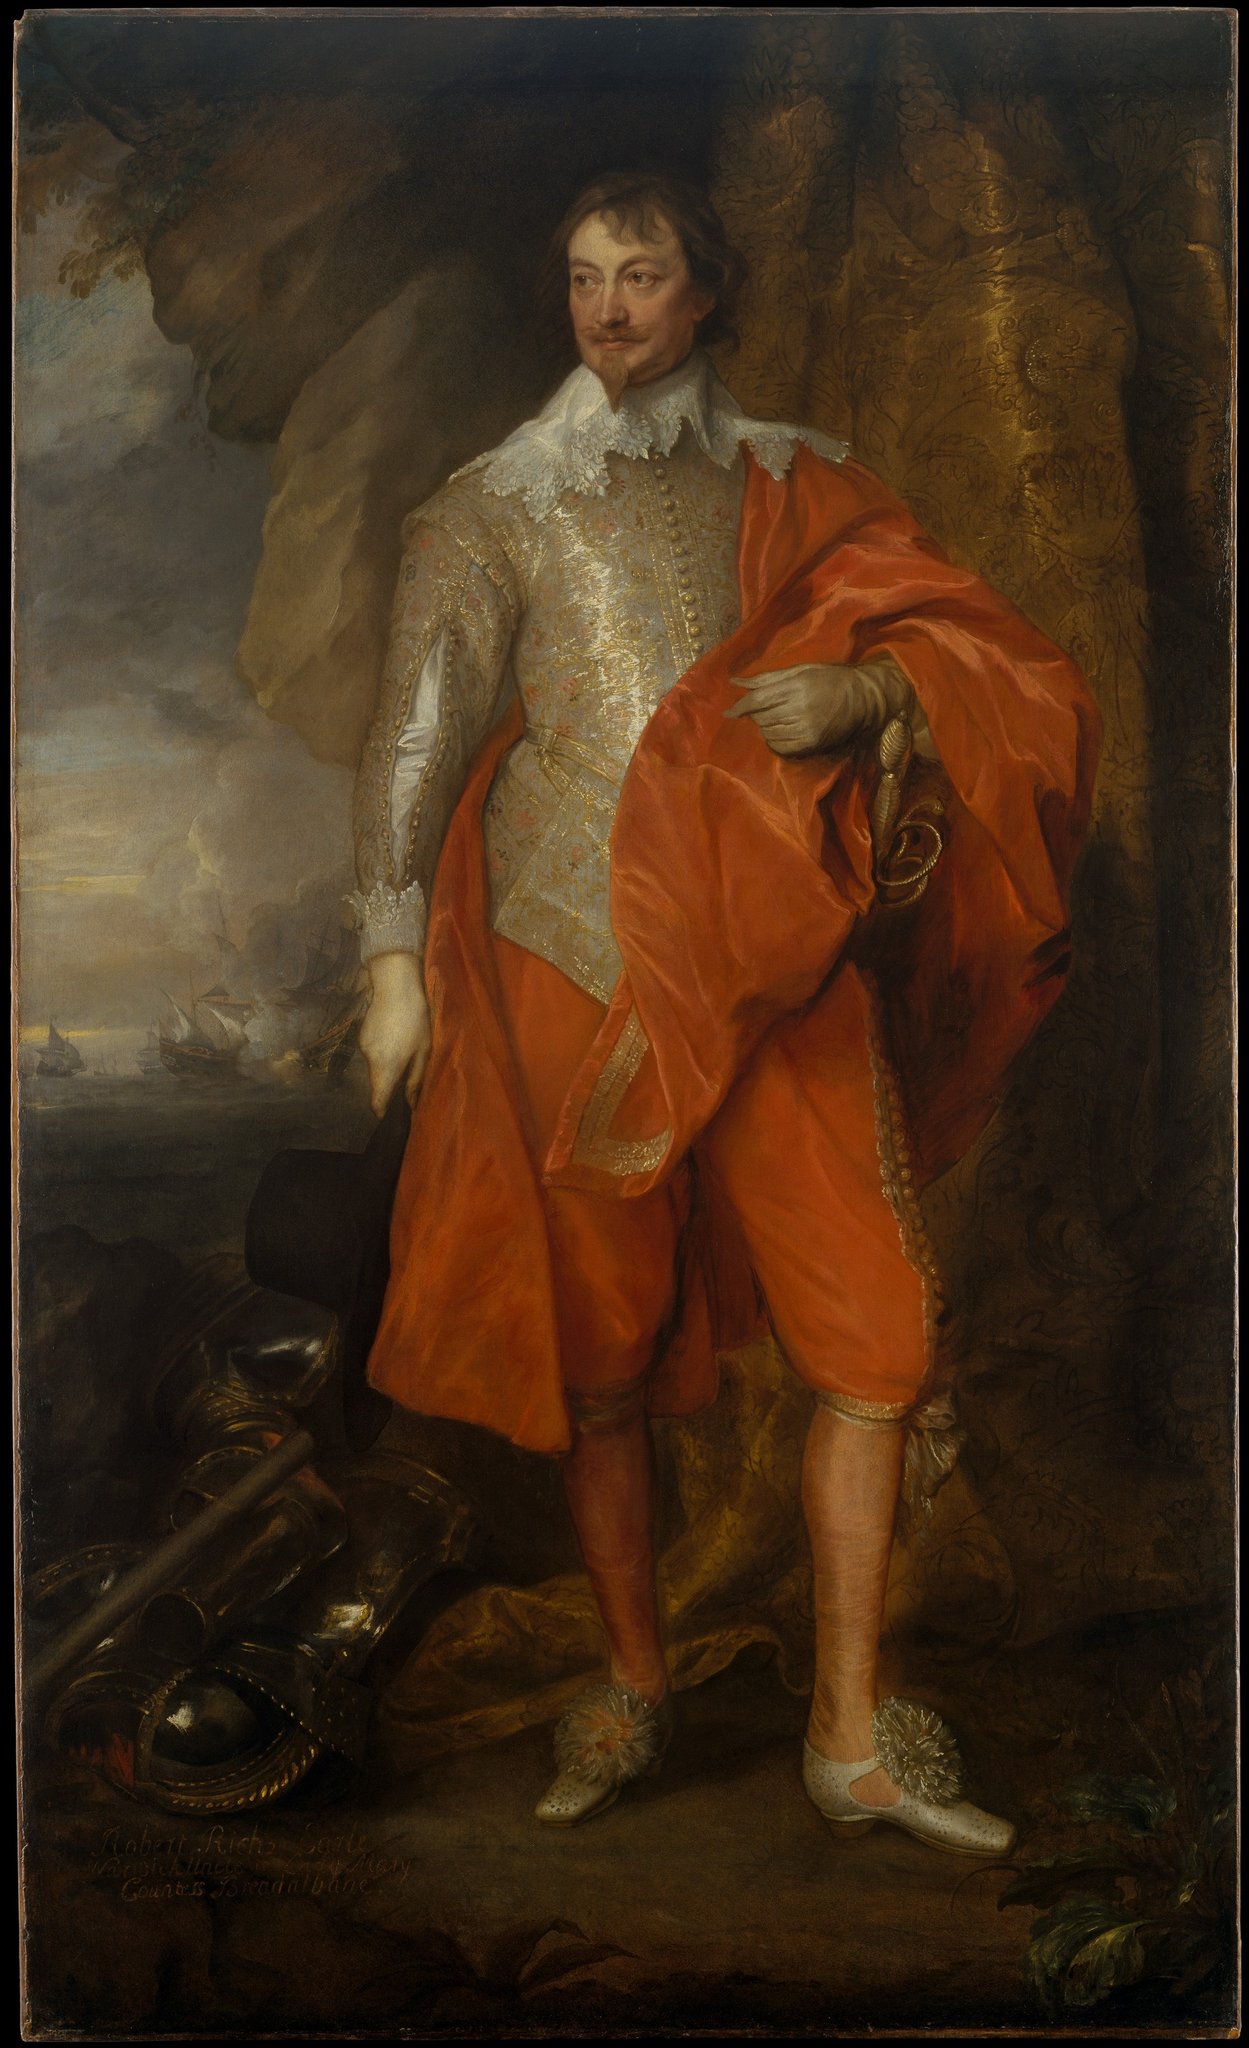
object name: painting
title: Robert Rich (1587–1658), Second Earl of Warwick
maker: anthony van dyck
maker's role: artist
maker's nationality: flemish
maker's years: 1599-1641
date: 1632-1635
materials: canvas, oil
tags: men,portraits